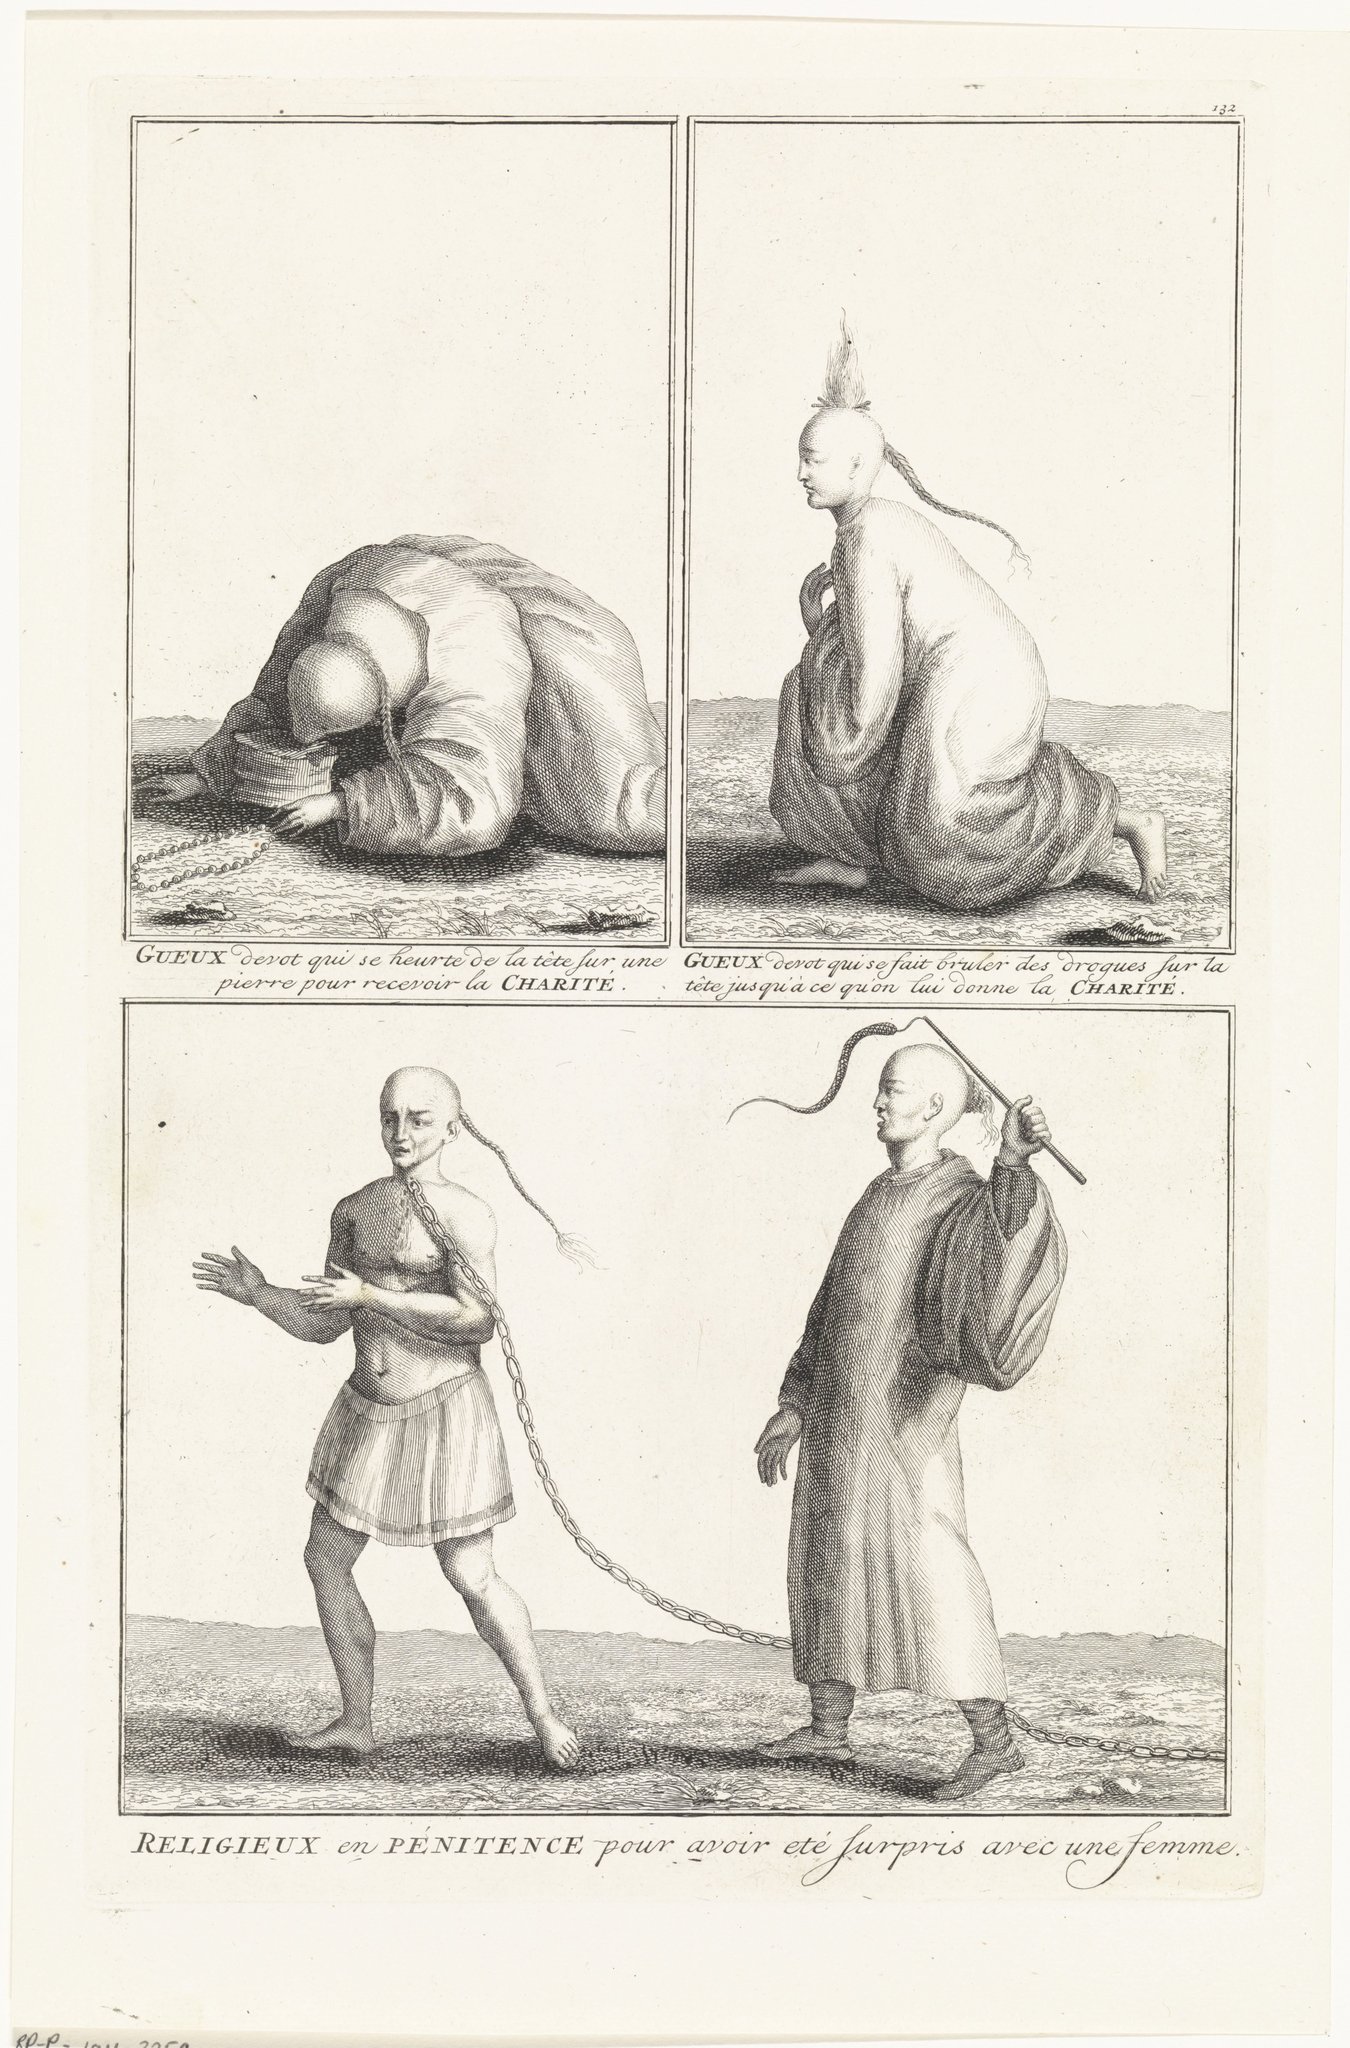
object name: print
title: Gueux devor qui se heurte de la tête sur une pierre pour recevoir la Charité (...)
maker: bernard picart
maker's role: draughtsman, print maker, publisher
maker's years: 1673-1733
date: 1728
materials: paper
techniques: engraving, etching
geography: amsterdam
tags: religious functionaries ~ traditional chinese religions, penitence, repentance; 'penitenza', 'pentimento', 'pentimento de'peccati', 'purgatione de peccati' (ripa)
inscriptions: collector's mark: Lugt 2228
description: Blad met drie voorstellingen van Chinese bedelmonniken. Linksboven: Een bedelmonnik stoot zijn hoofd tegen een steen om liefdadigheid van voorbijgangers te ontvangen. Rechtsboven: Een bedelmonnik heeft een vuur op zijn hoofd aangestoken om liefdadigheid van voorbijgangers te ontvangen. Onder: Een geestelijke doet boete en wordt gegeseld, omdat hij met een vrouw is gezien. Rechtsboven genummerd: 132.